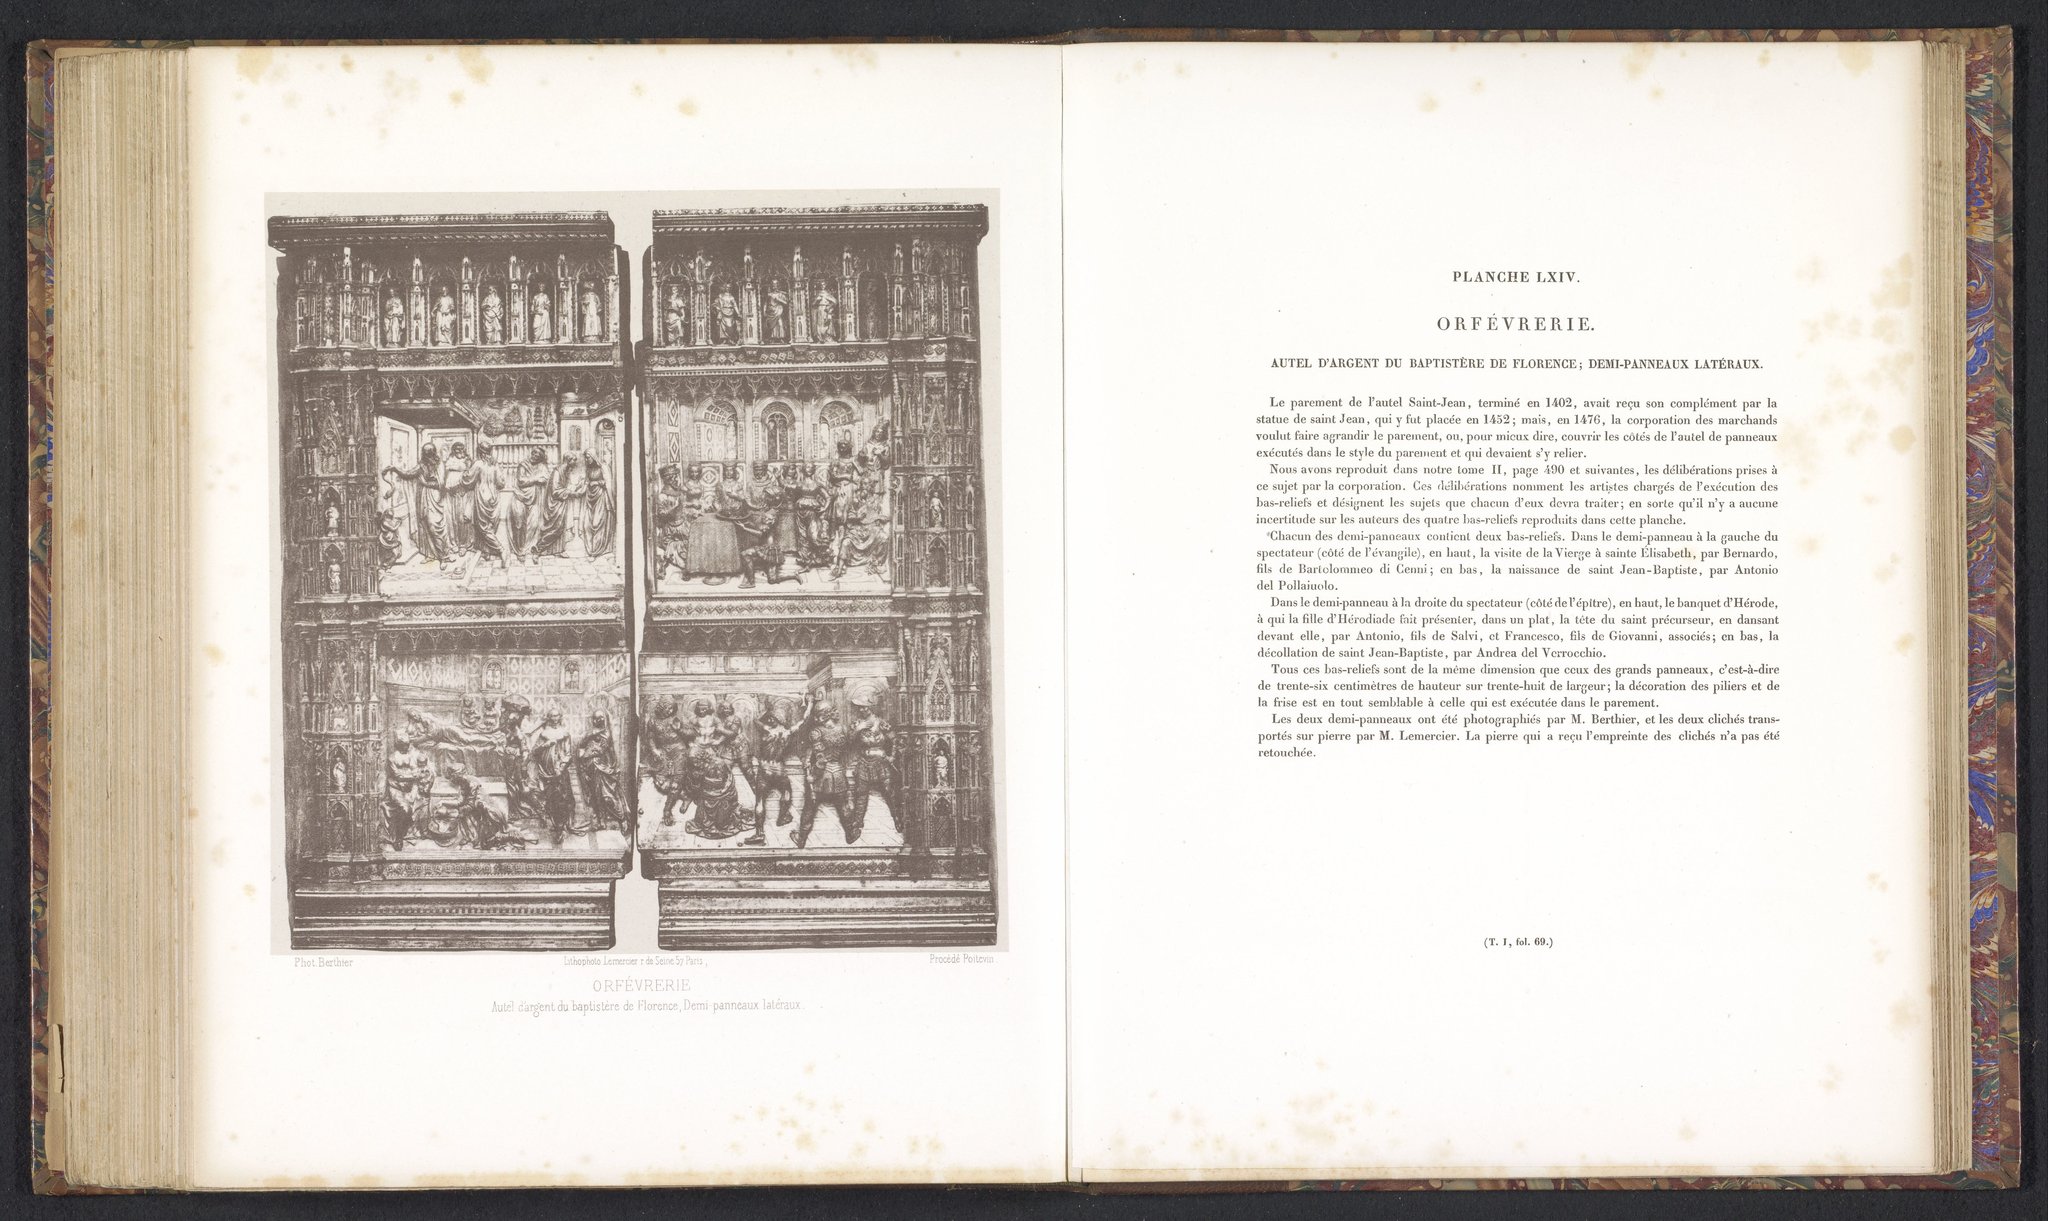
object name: photomechanical print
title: Orfévrerie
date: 1859-1864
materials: paper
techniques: photolithography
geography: paris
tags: series of scenes from the life of john the baptist, altar, sculpture (+ relief ~ sculpture)